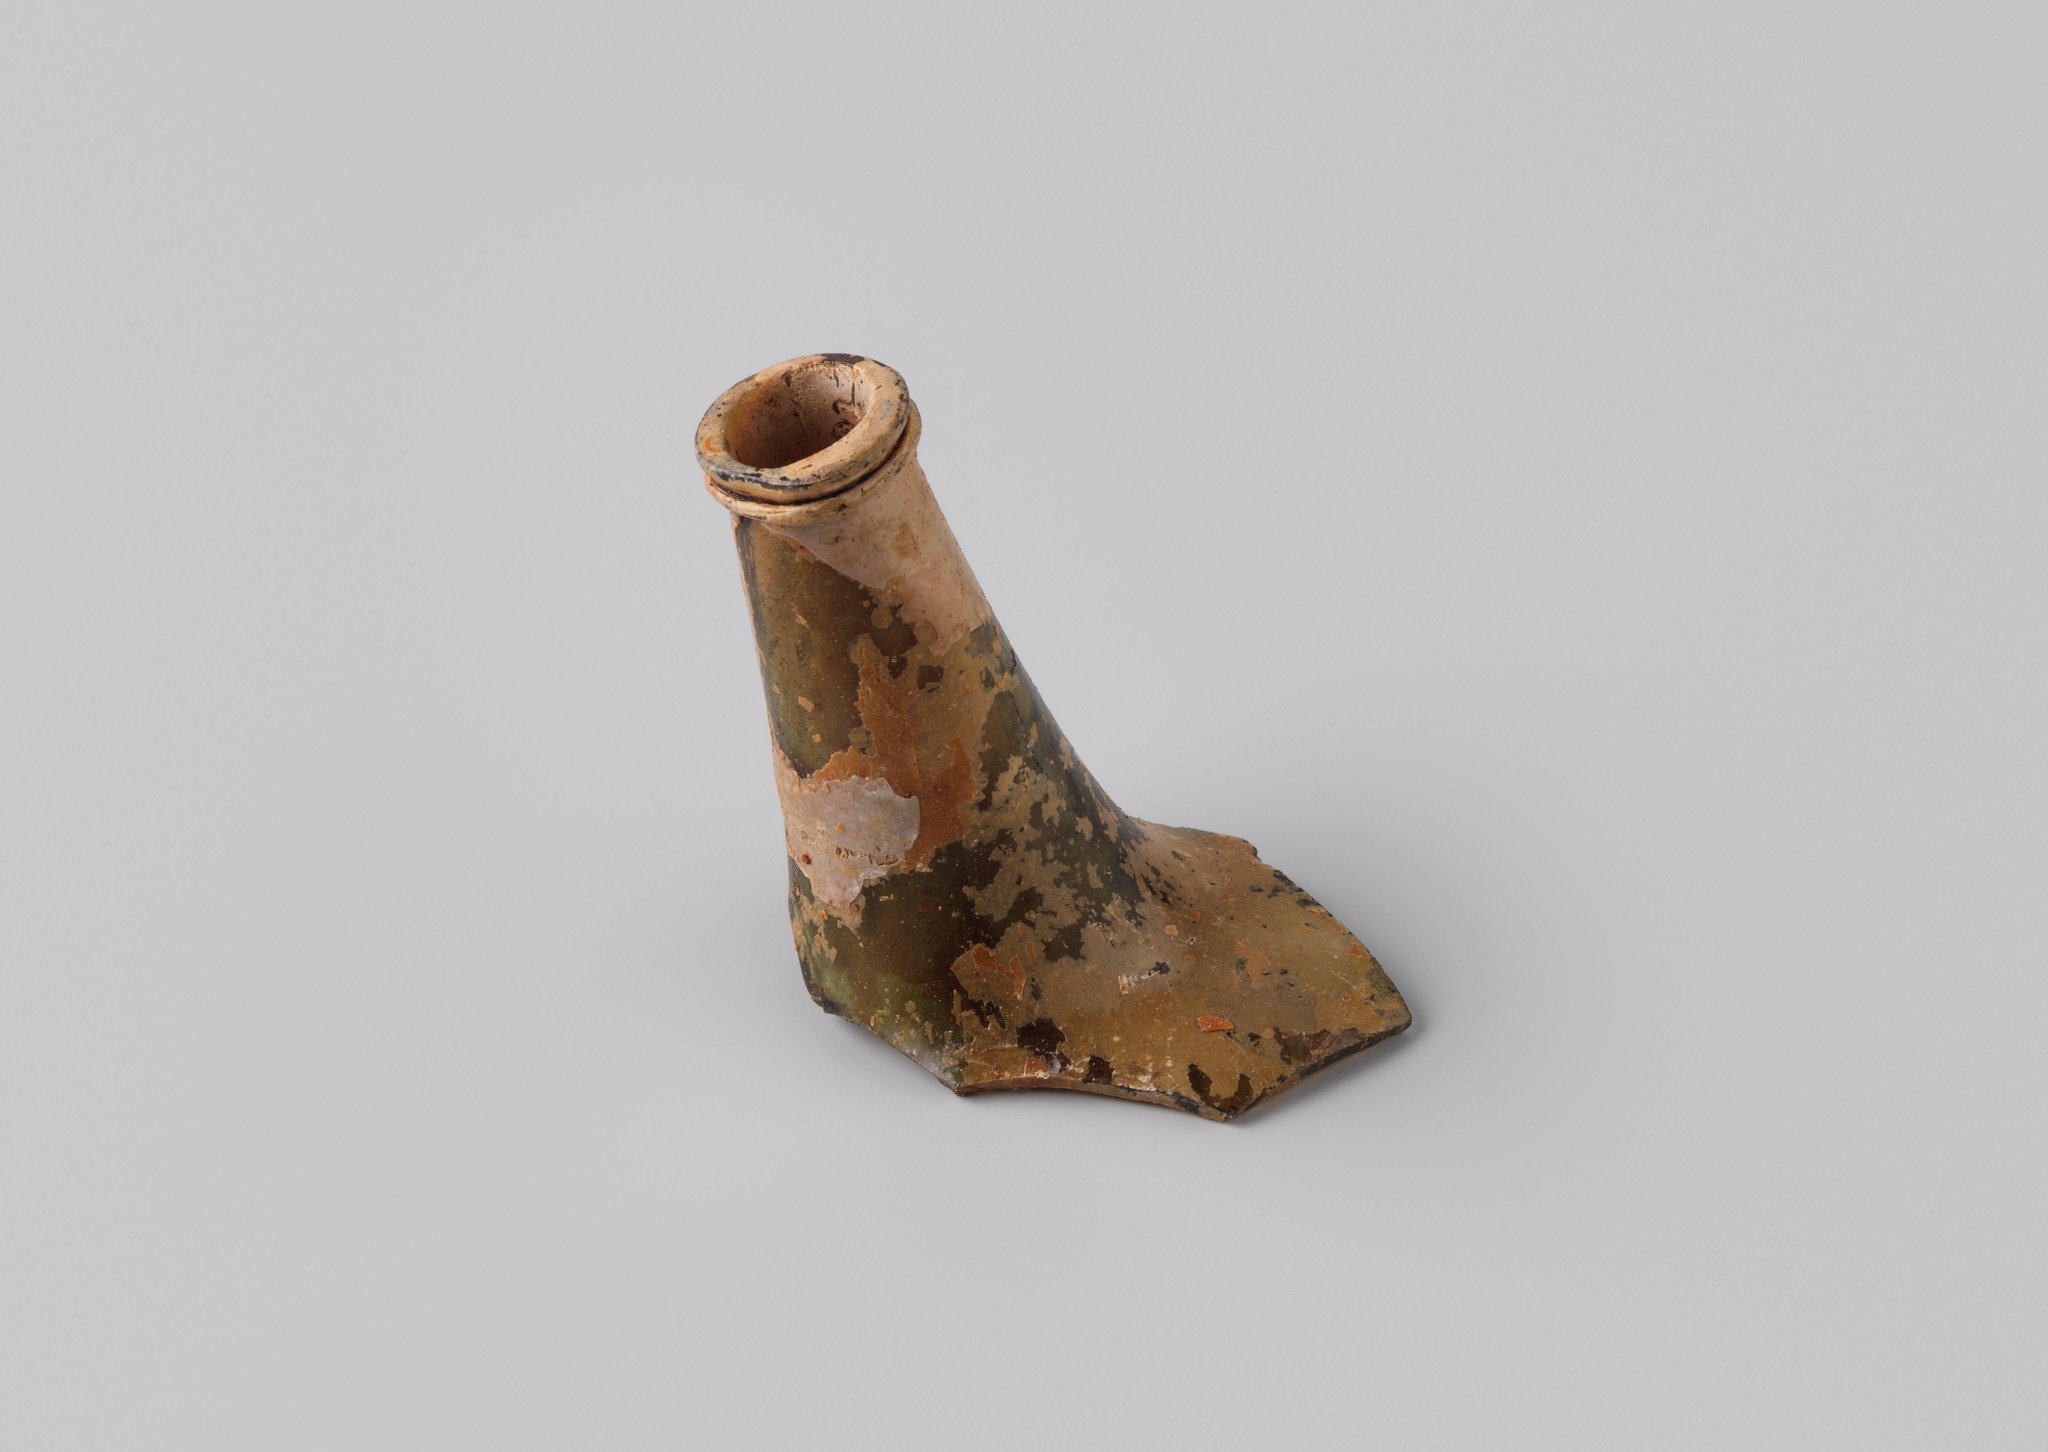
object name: neck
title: Hals van een wijnfles uit het wrak van de Oost-Indiëvaarder Hollandia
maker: Anonymous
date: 1700-1743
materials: glass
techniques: green glass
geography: netherlands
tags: verenigde oostindische compagnie, hollandia (schip), annet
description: Wine bottle, continental production, neck, onion-shaped bottle or bottle with vertical side; eroded, narrow vs-string rim.